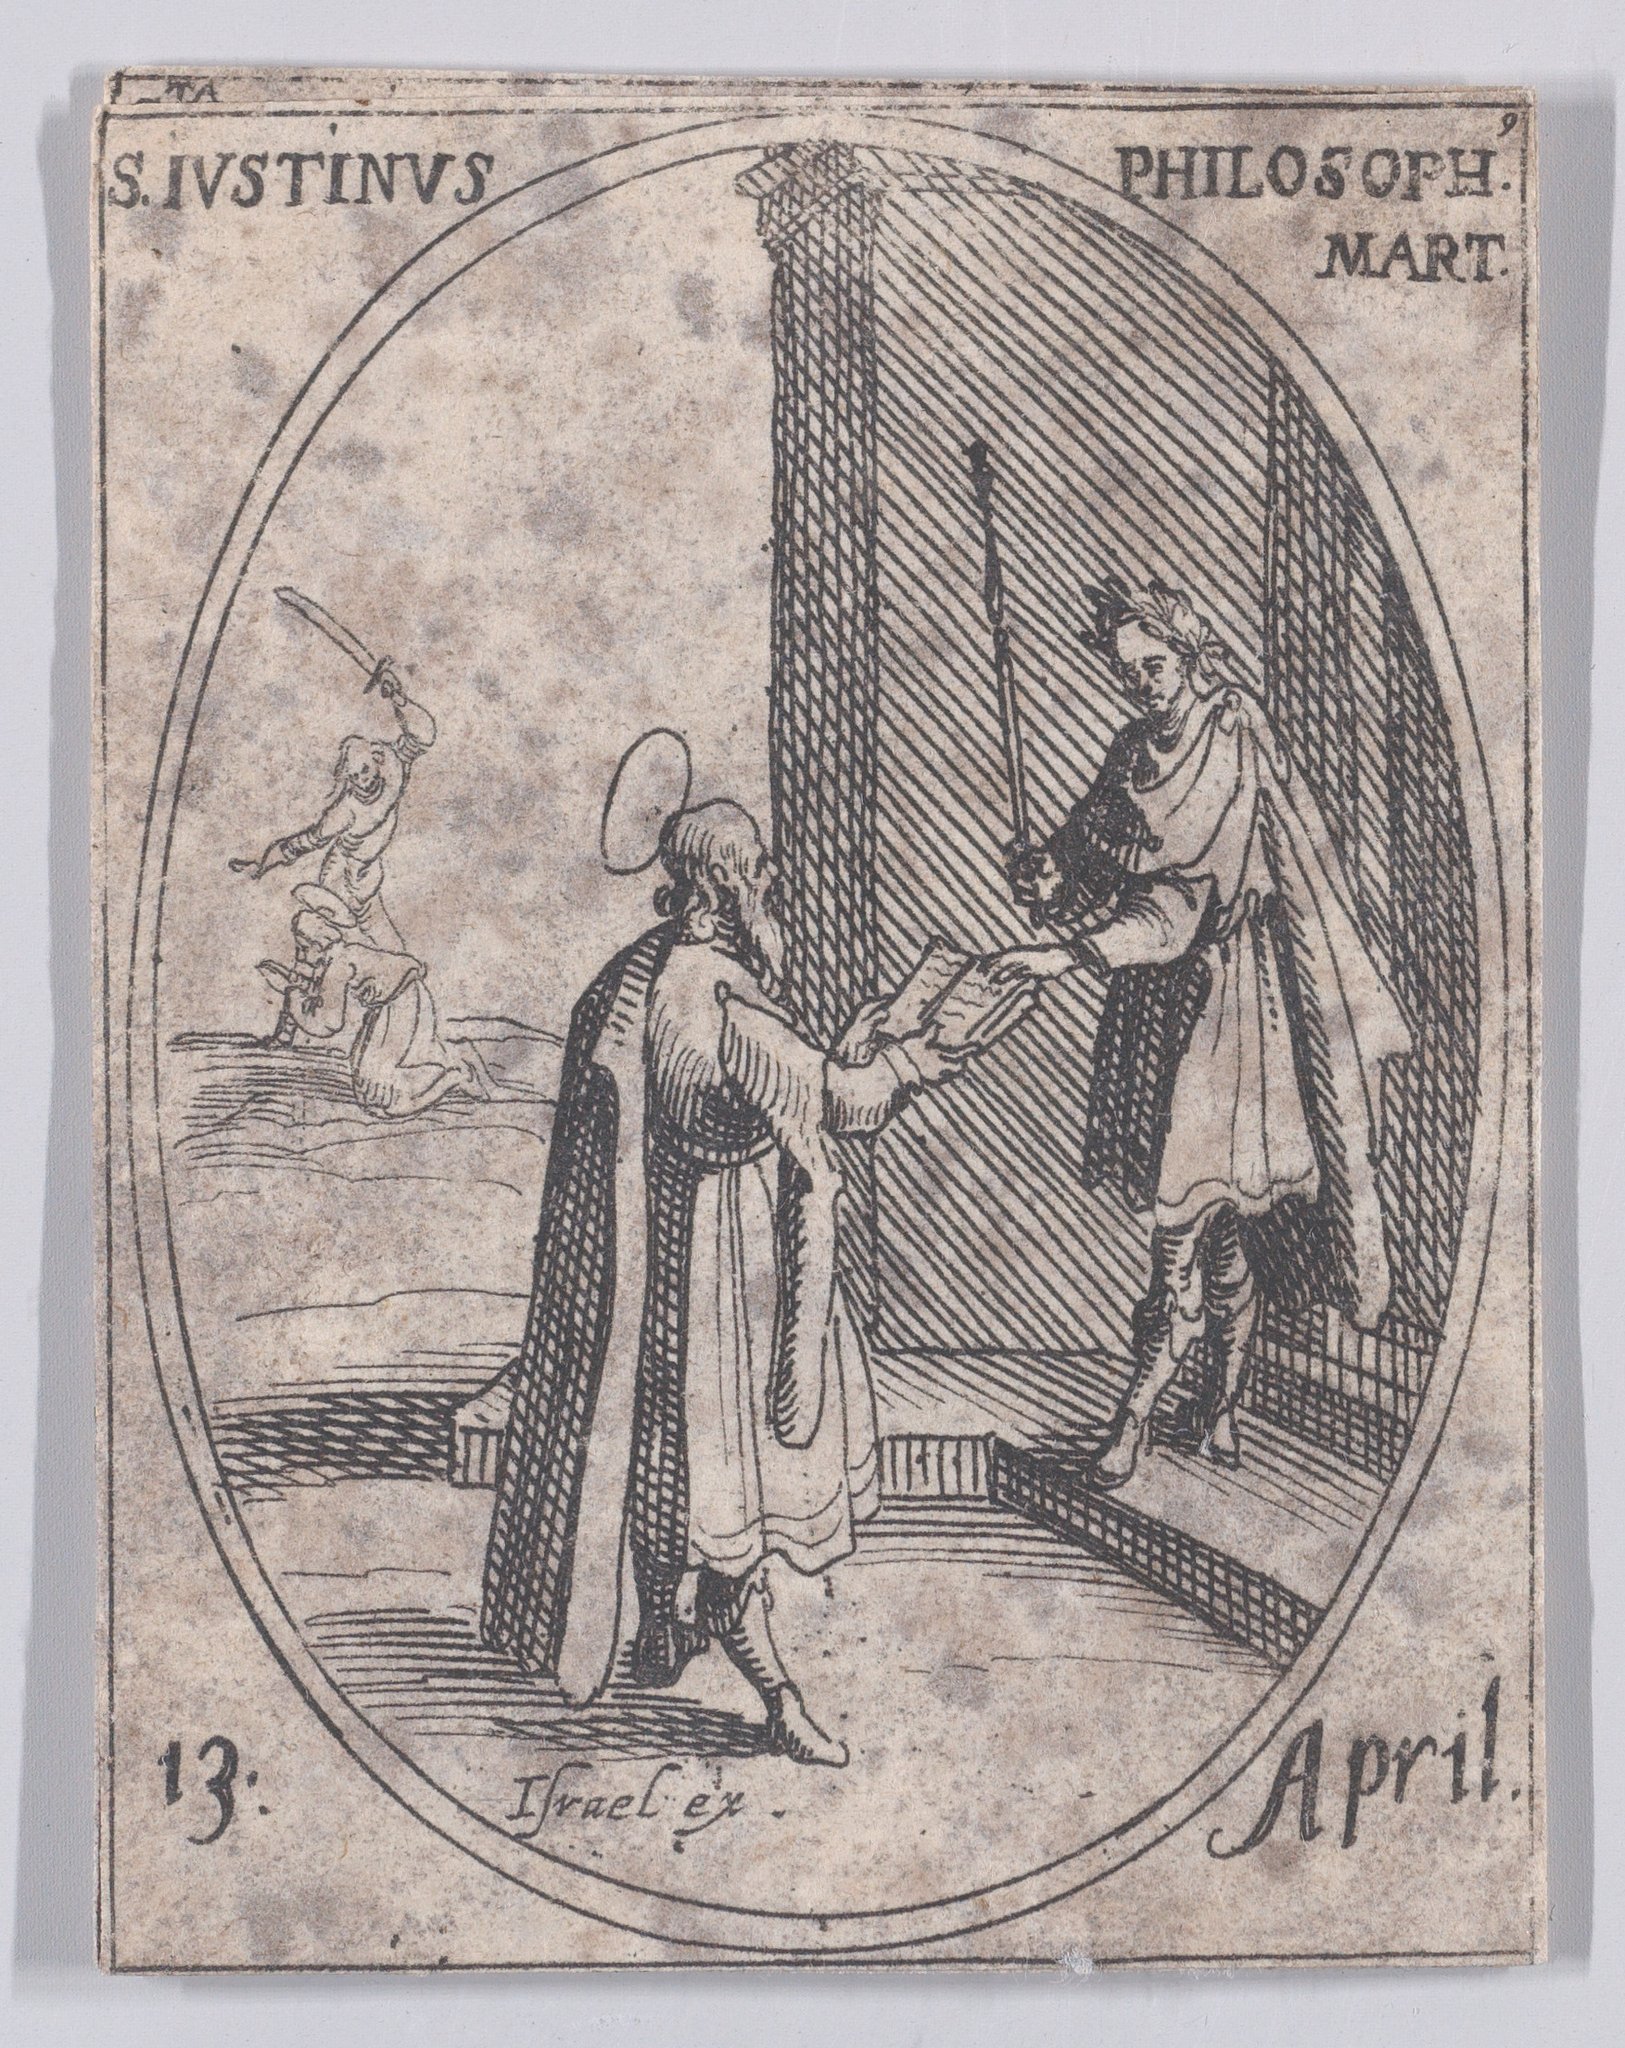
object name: print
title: S. Justin, philosophe (St. Justin, Philosopher), April 13th, from "Les Images De Tous Les Saincts et Saintes de L'Année" (Images of All of the Saints and Religious Events of the Year)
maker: jacques callot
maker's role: artist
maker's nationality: french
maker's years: 1592-1635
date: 1636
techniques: etching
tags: men,saints